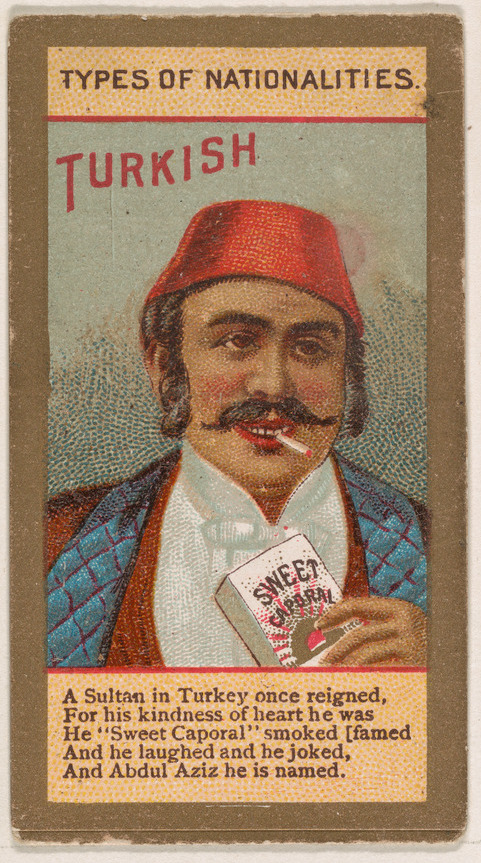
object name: print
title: Turkish, from Types of Nationalities (N240) issued by Kinney Bros.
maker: kinney brothers tobacco company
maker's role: publisher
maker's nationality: american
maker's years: 1869-2011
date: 1890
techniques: color lithograph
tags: men,smoking